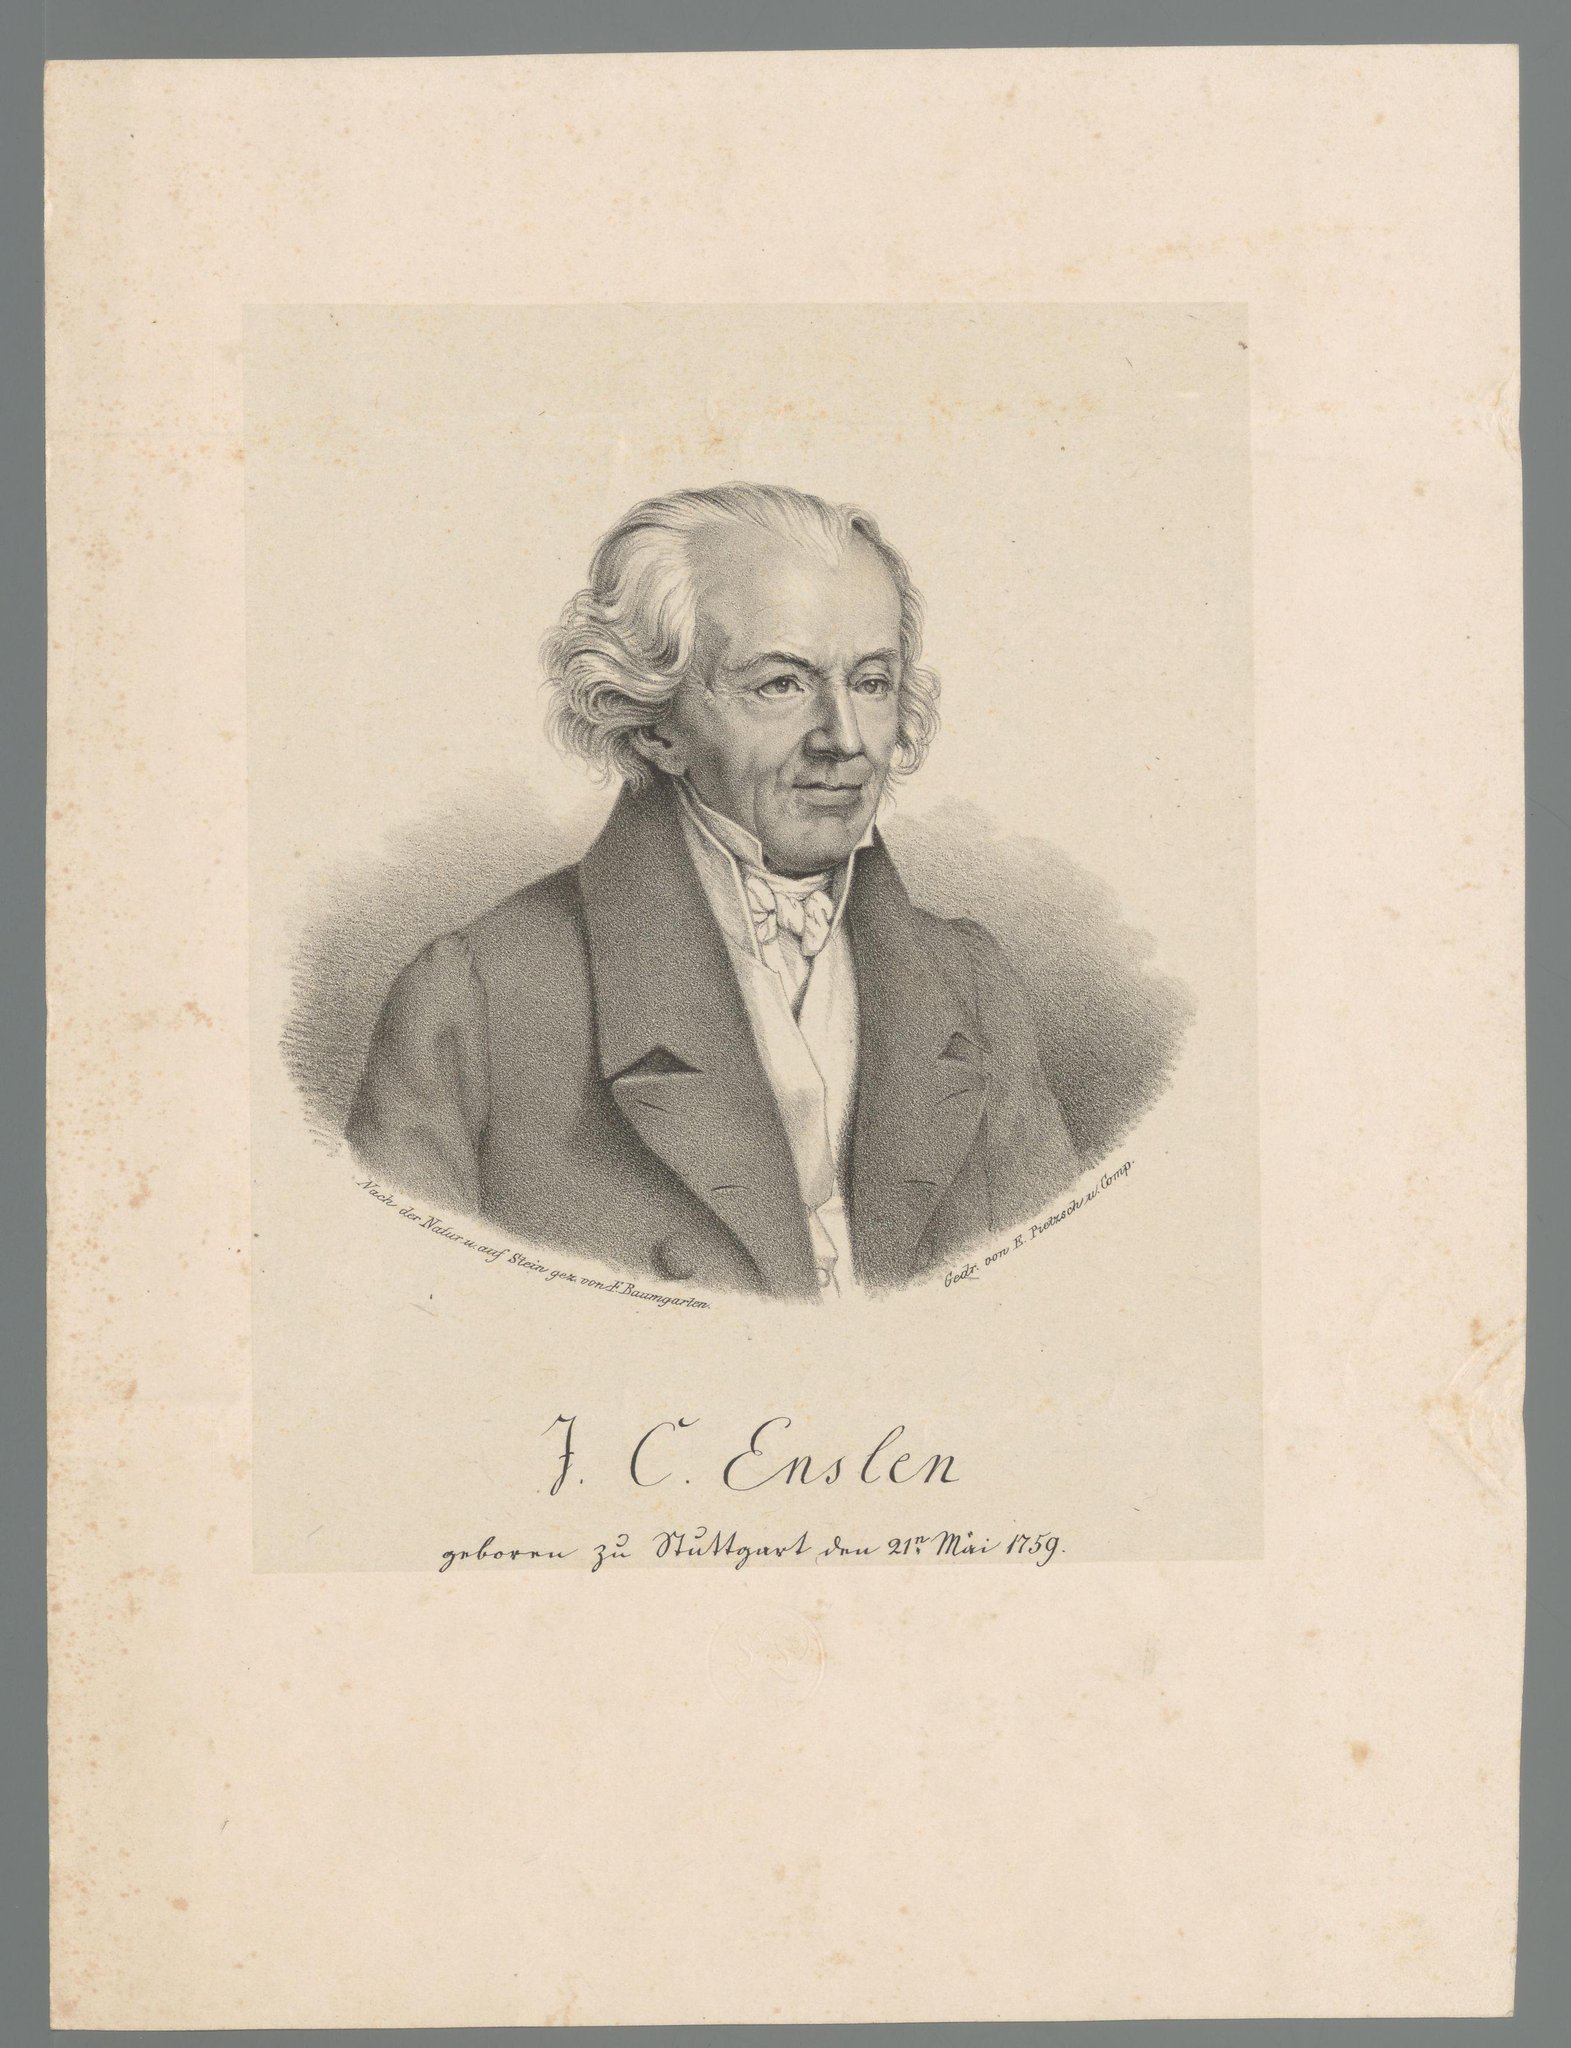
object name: print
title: Portret van Johann Carl Enslen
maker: f. baumgarten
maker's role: print maker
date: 1825-1899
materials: paper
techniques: lithograph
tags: historical persons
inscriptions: check stamp: ‘LL Berlin’, collector's mark: Lugt 2228